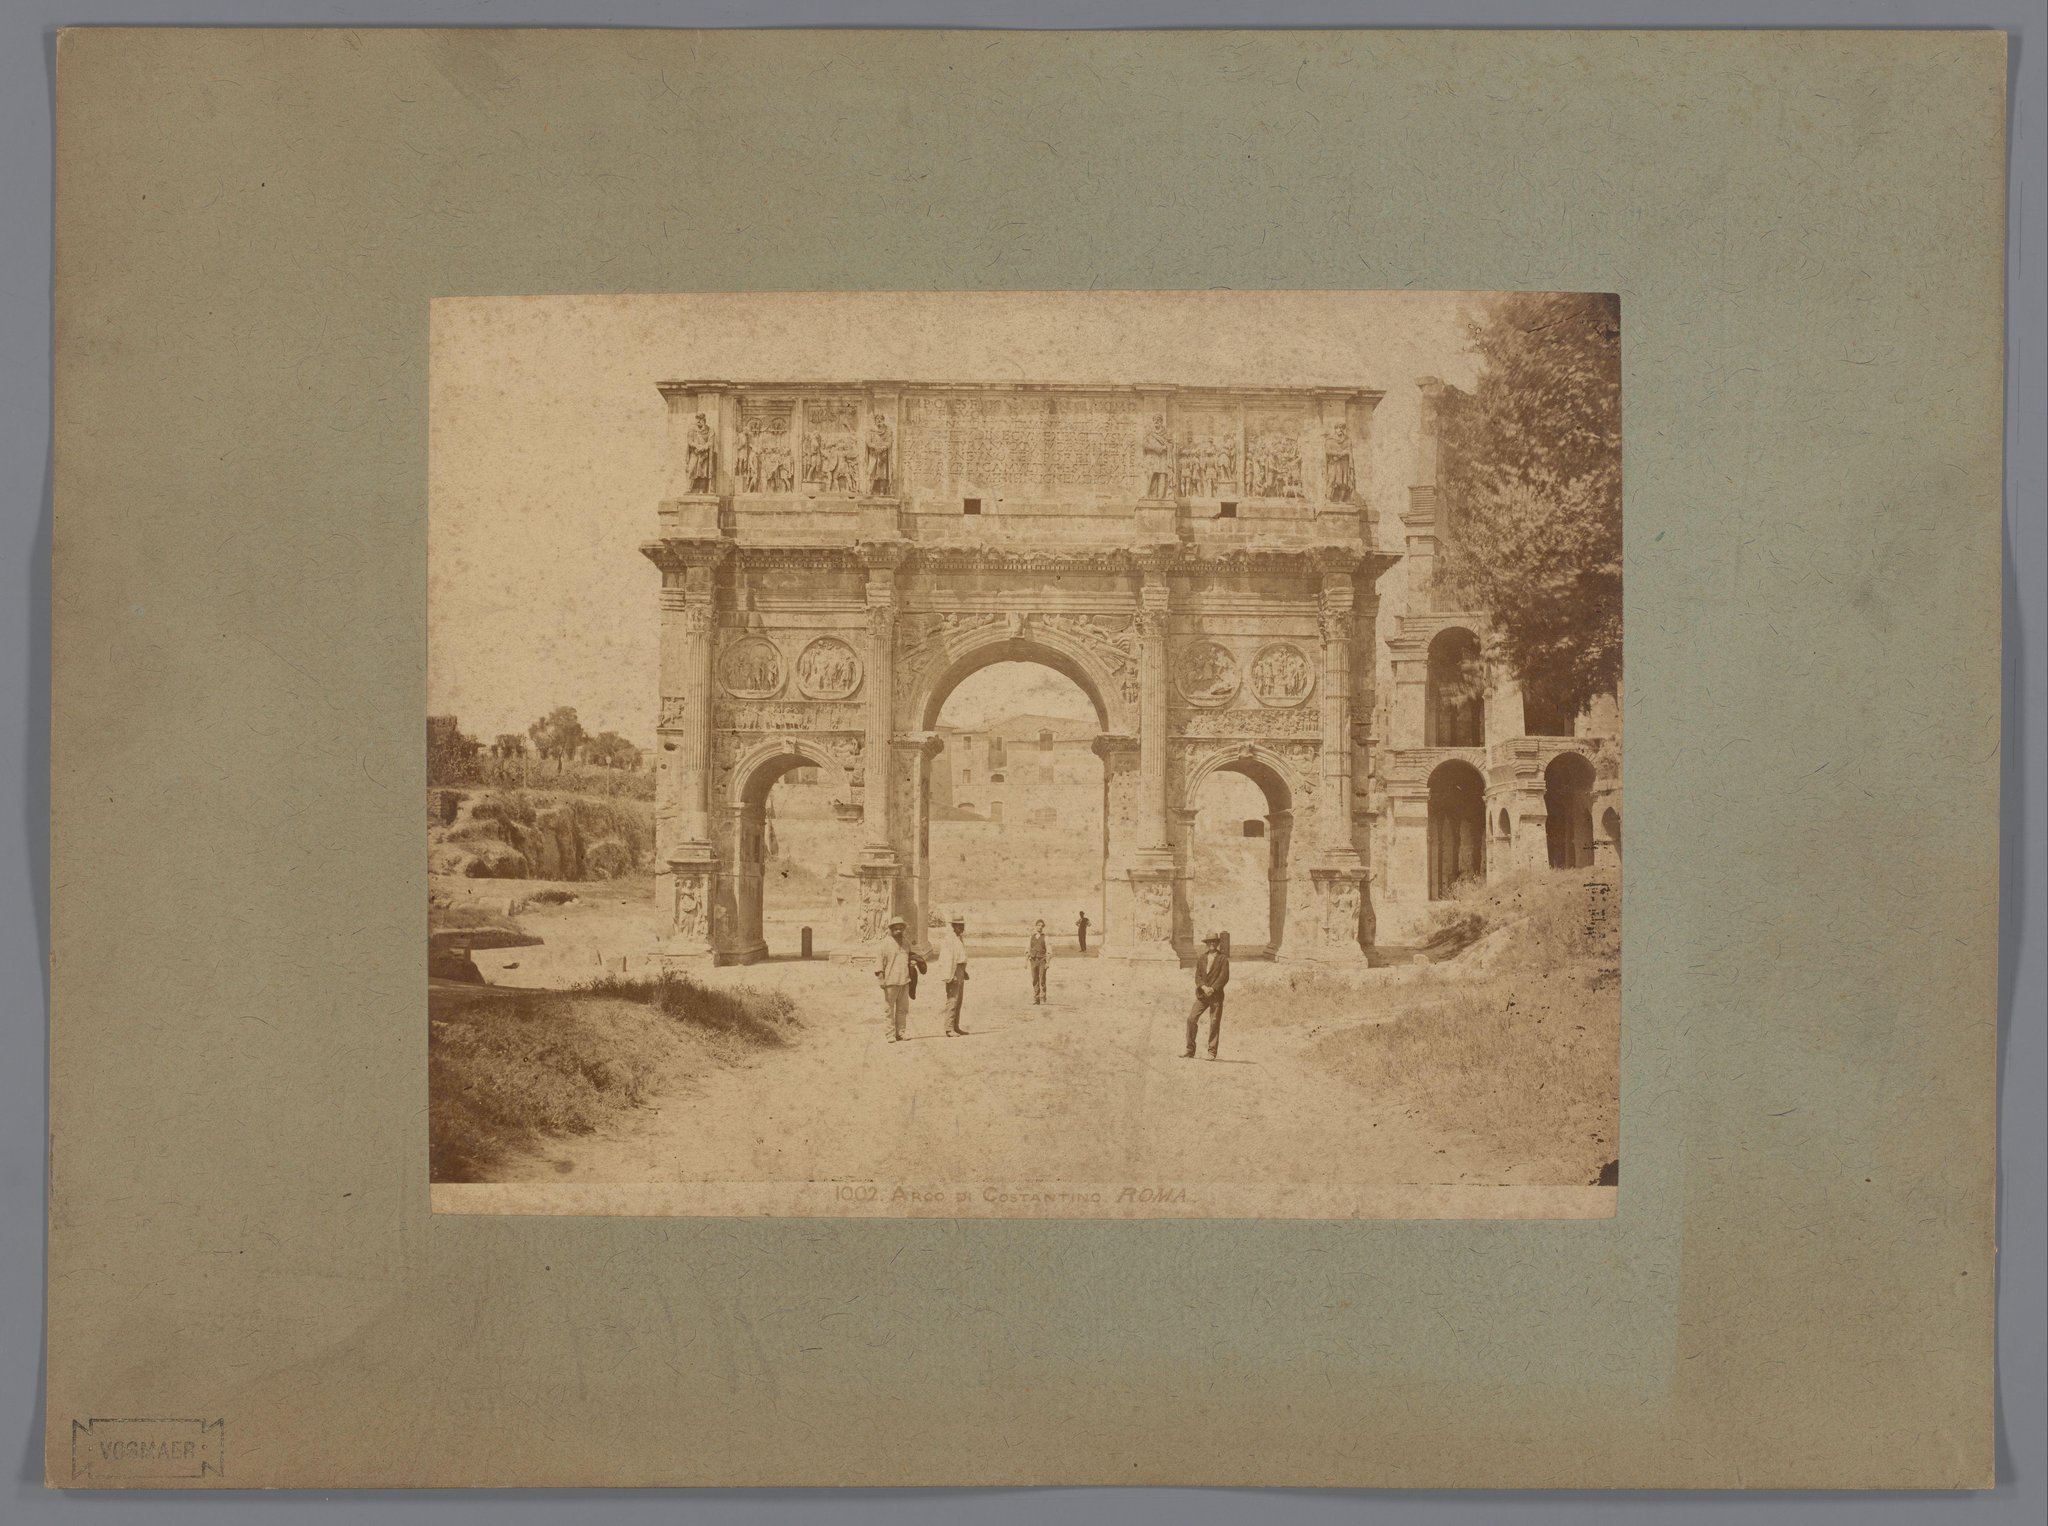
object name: photograph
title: Triomfboog van Constantijn te Rome, Italië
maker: Anonymous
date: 1851-1900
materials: cardboard, paper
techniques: albumen print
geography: rome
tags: triumphal arch, rome, arch of constantine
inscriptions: number: ‘1002.’, collector's mark: ‘VOSMAER’